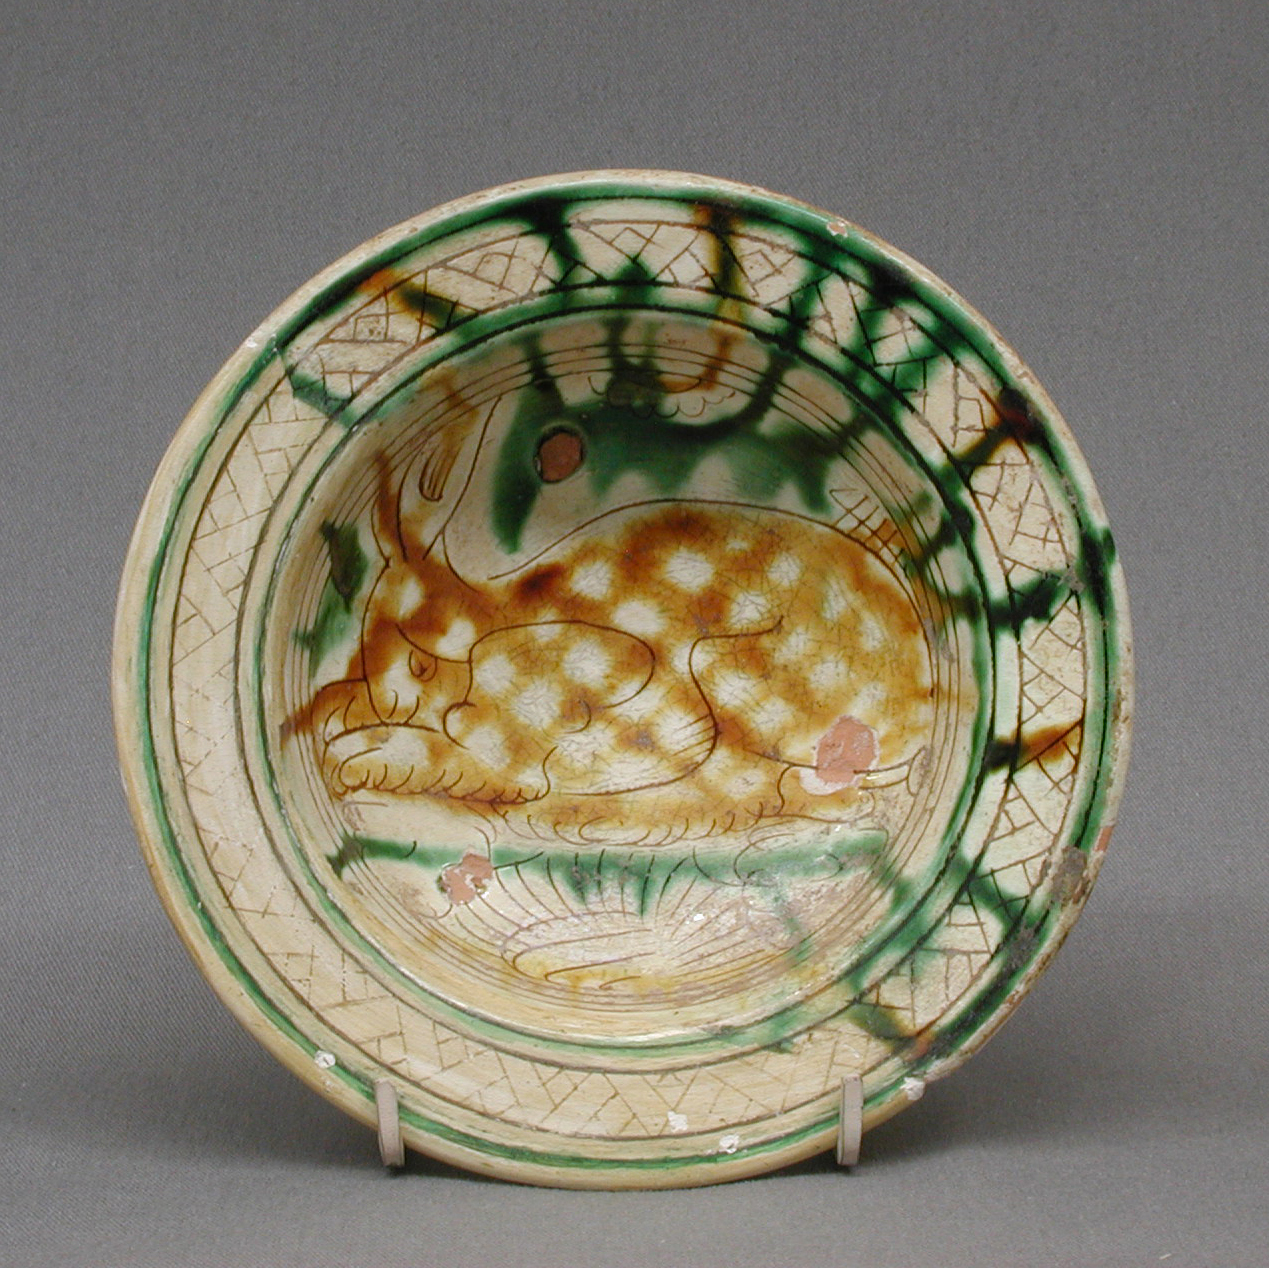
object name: bowl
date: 1601-1700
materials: earthenware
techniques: glazing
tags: rabbits